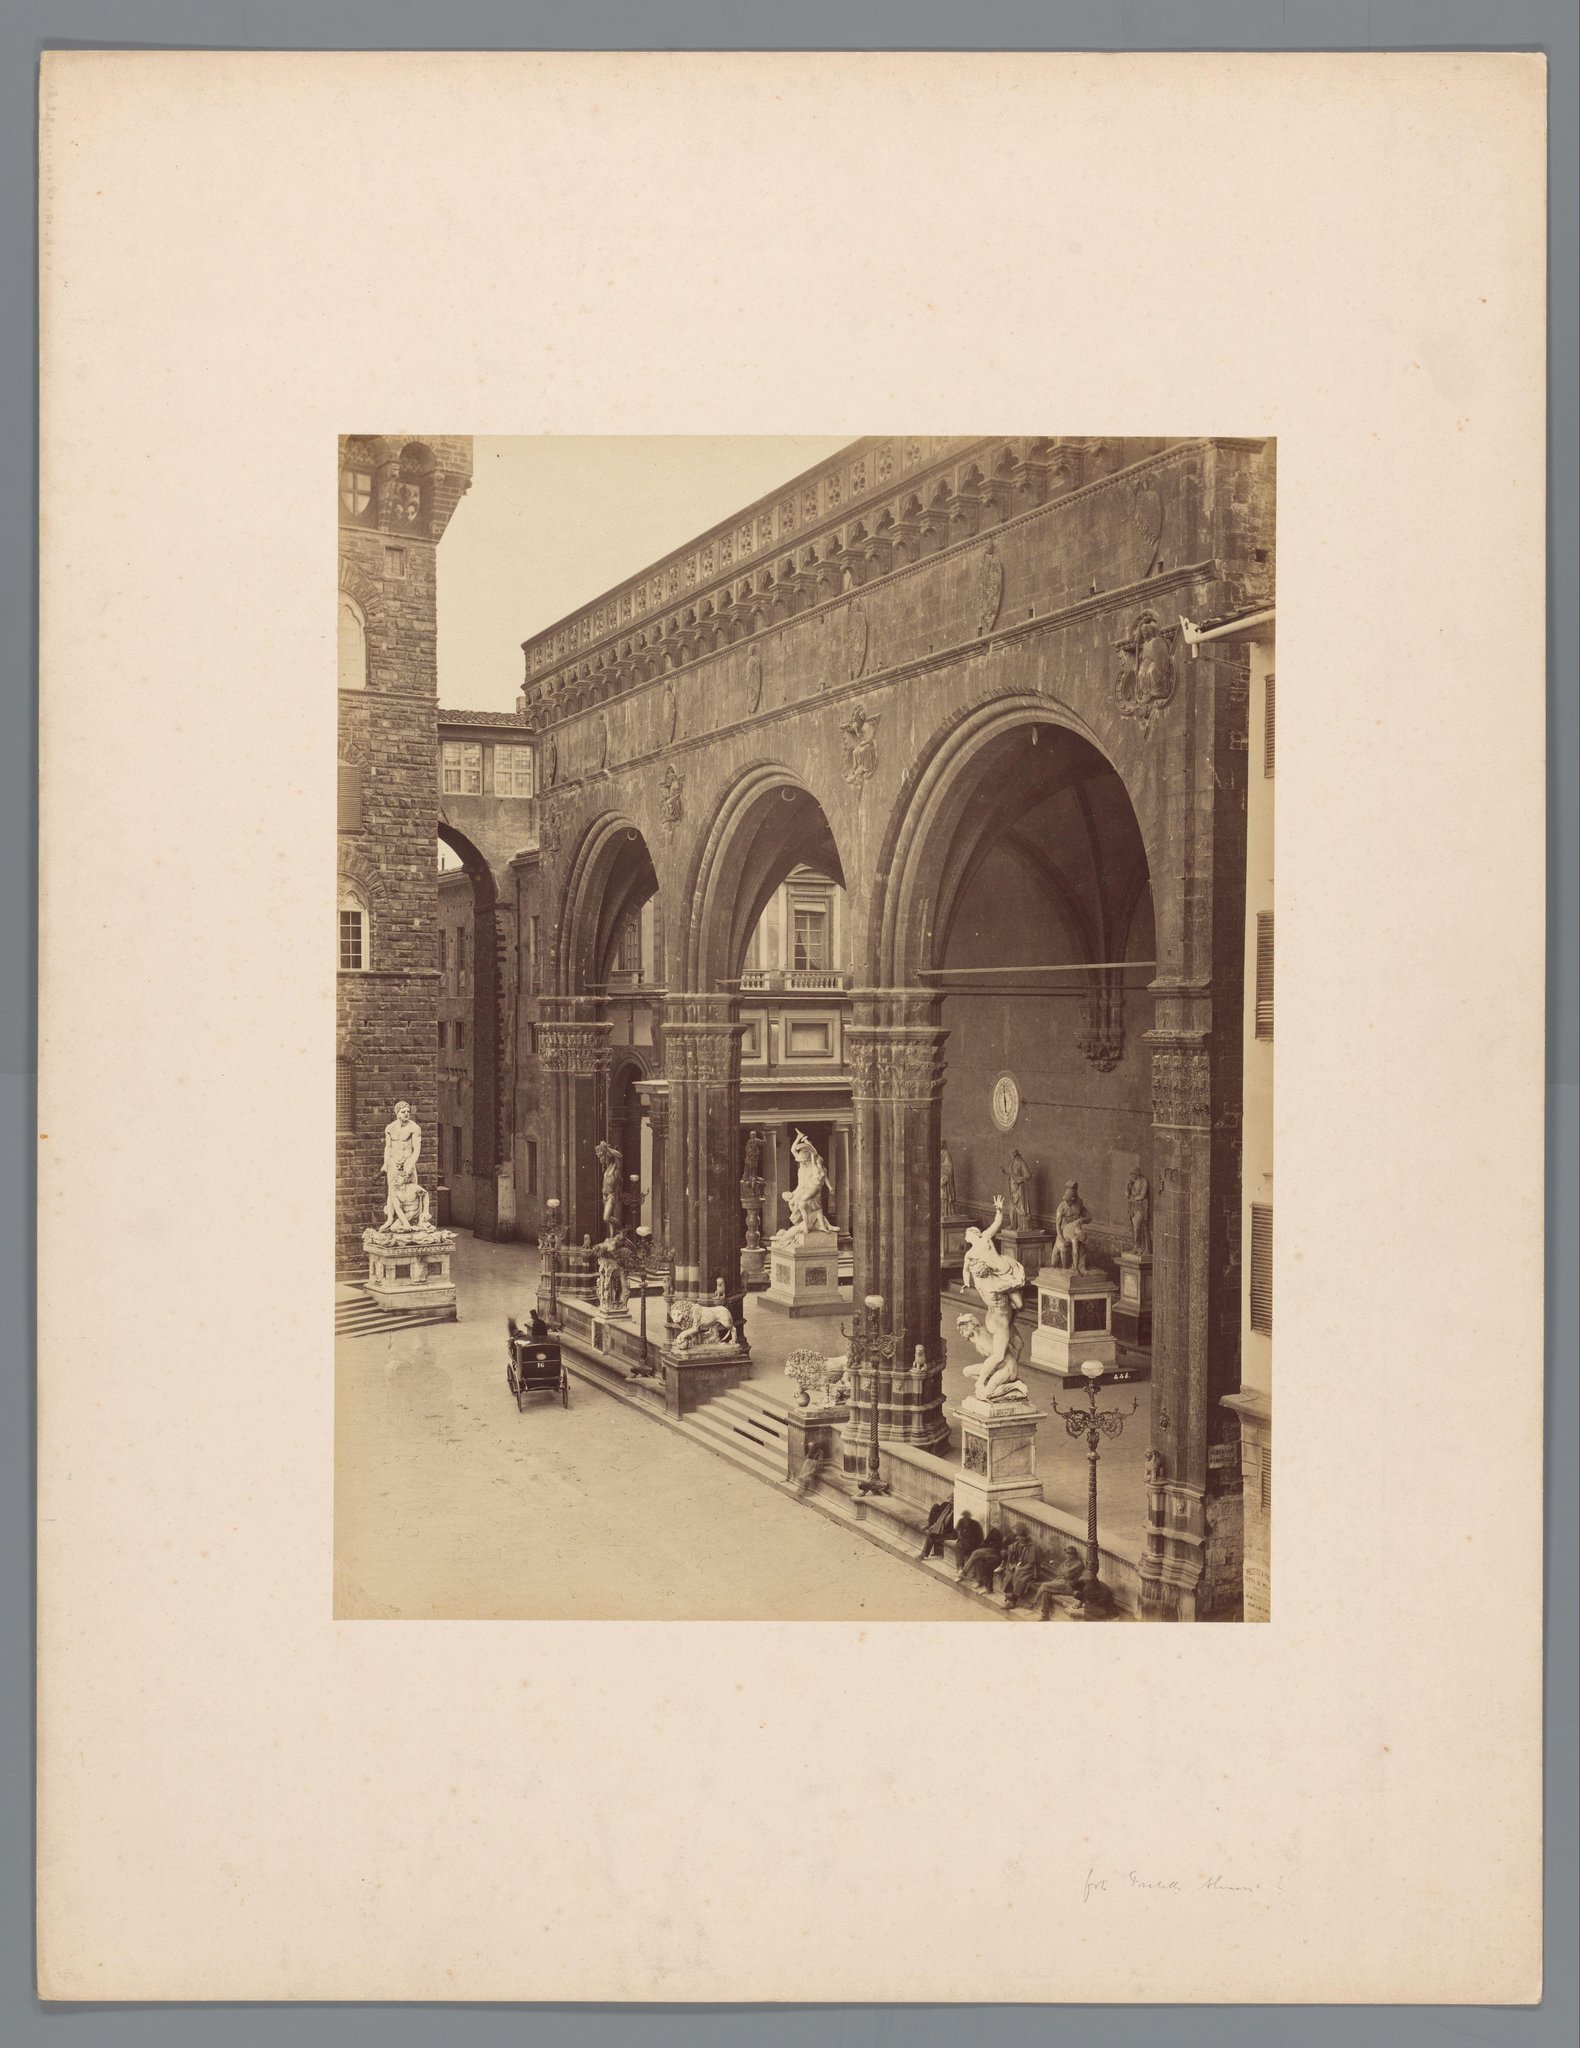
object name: photograph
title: Florence, Loggia dei Lanzi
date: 1865-1890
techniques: albumen print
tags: loggia dei lanzi